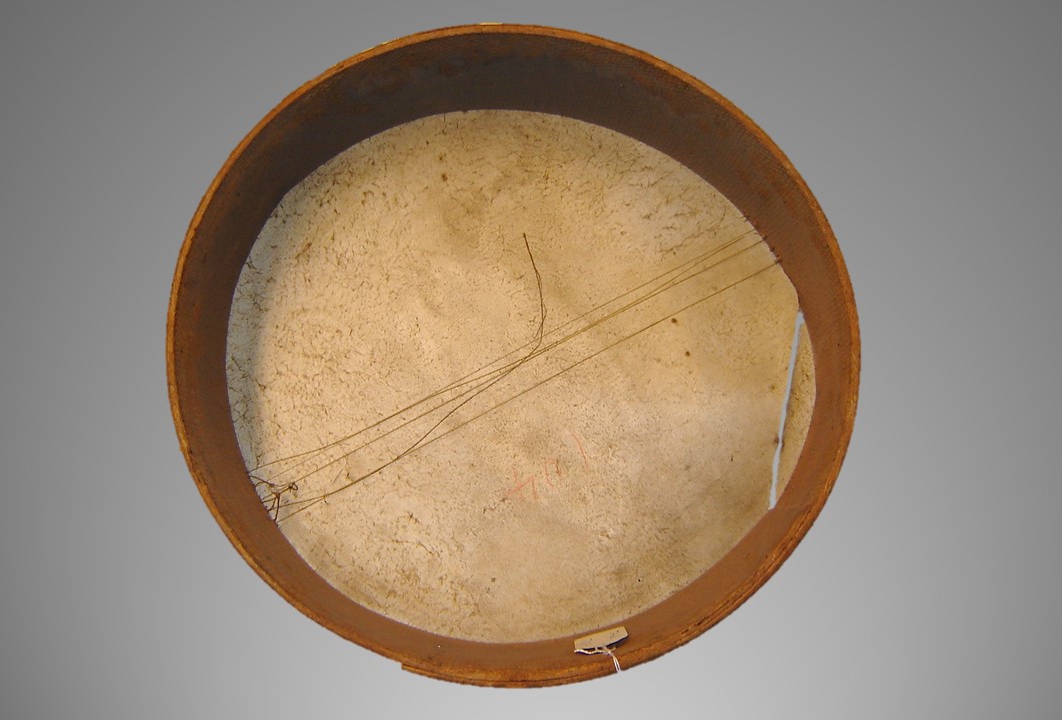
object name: bandar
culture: algerian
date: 1867-1900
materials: skin, wood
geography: algeria